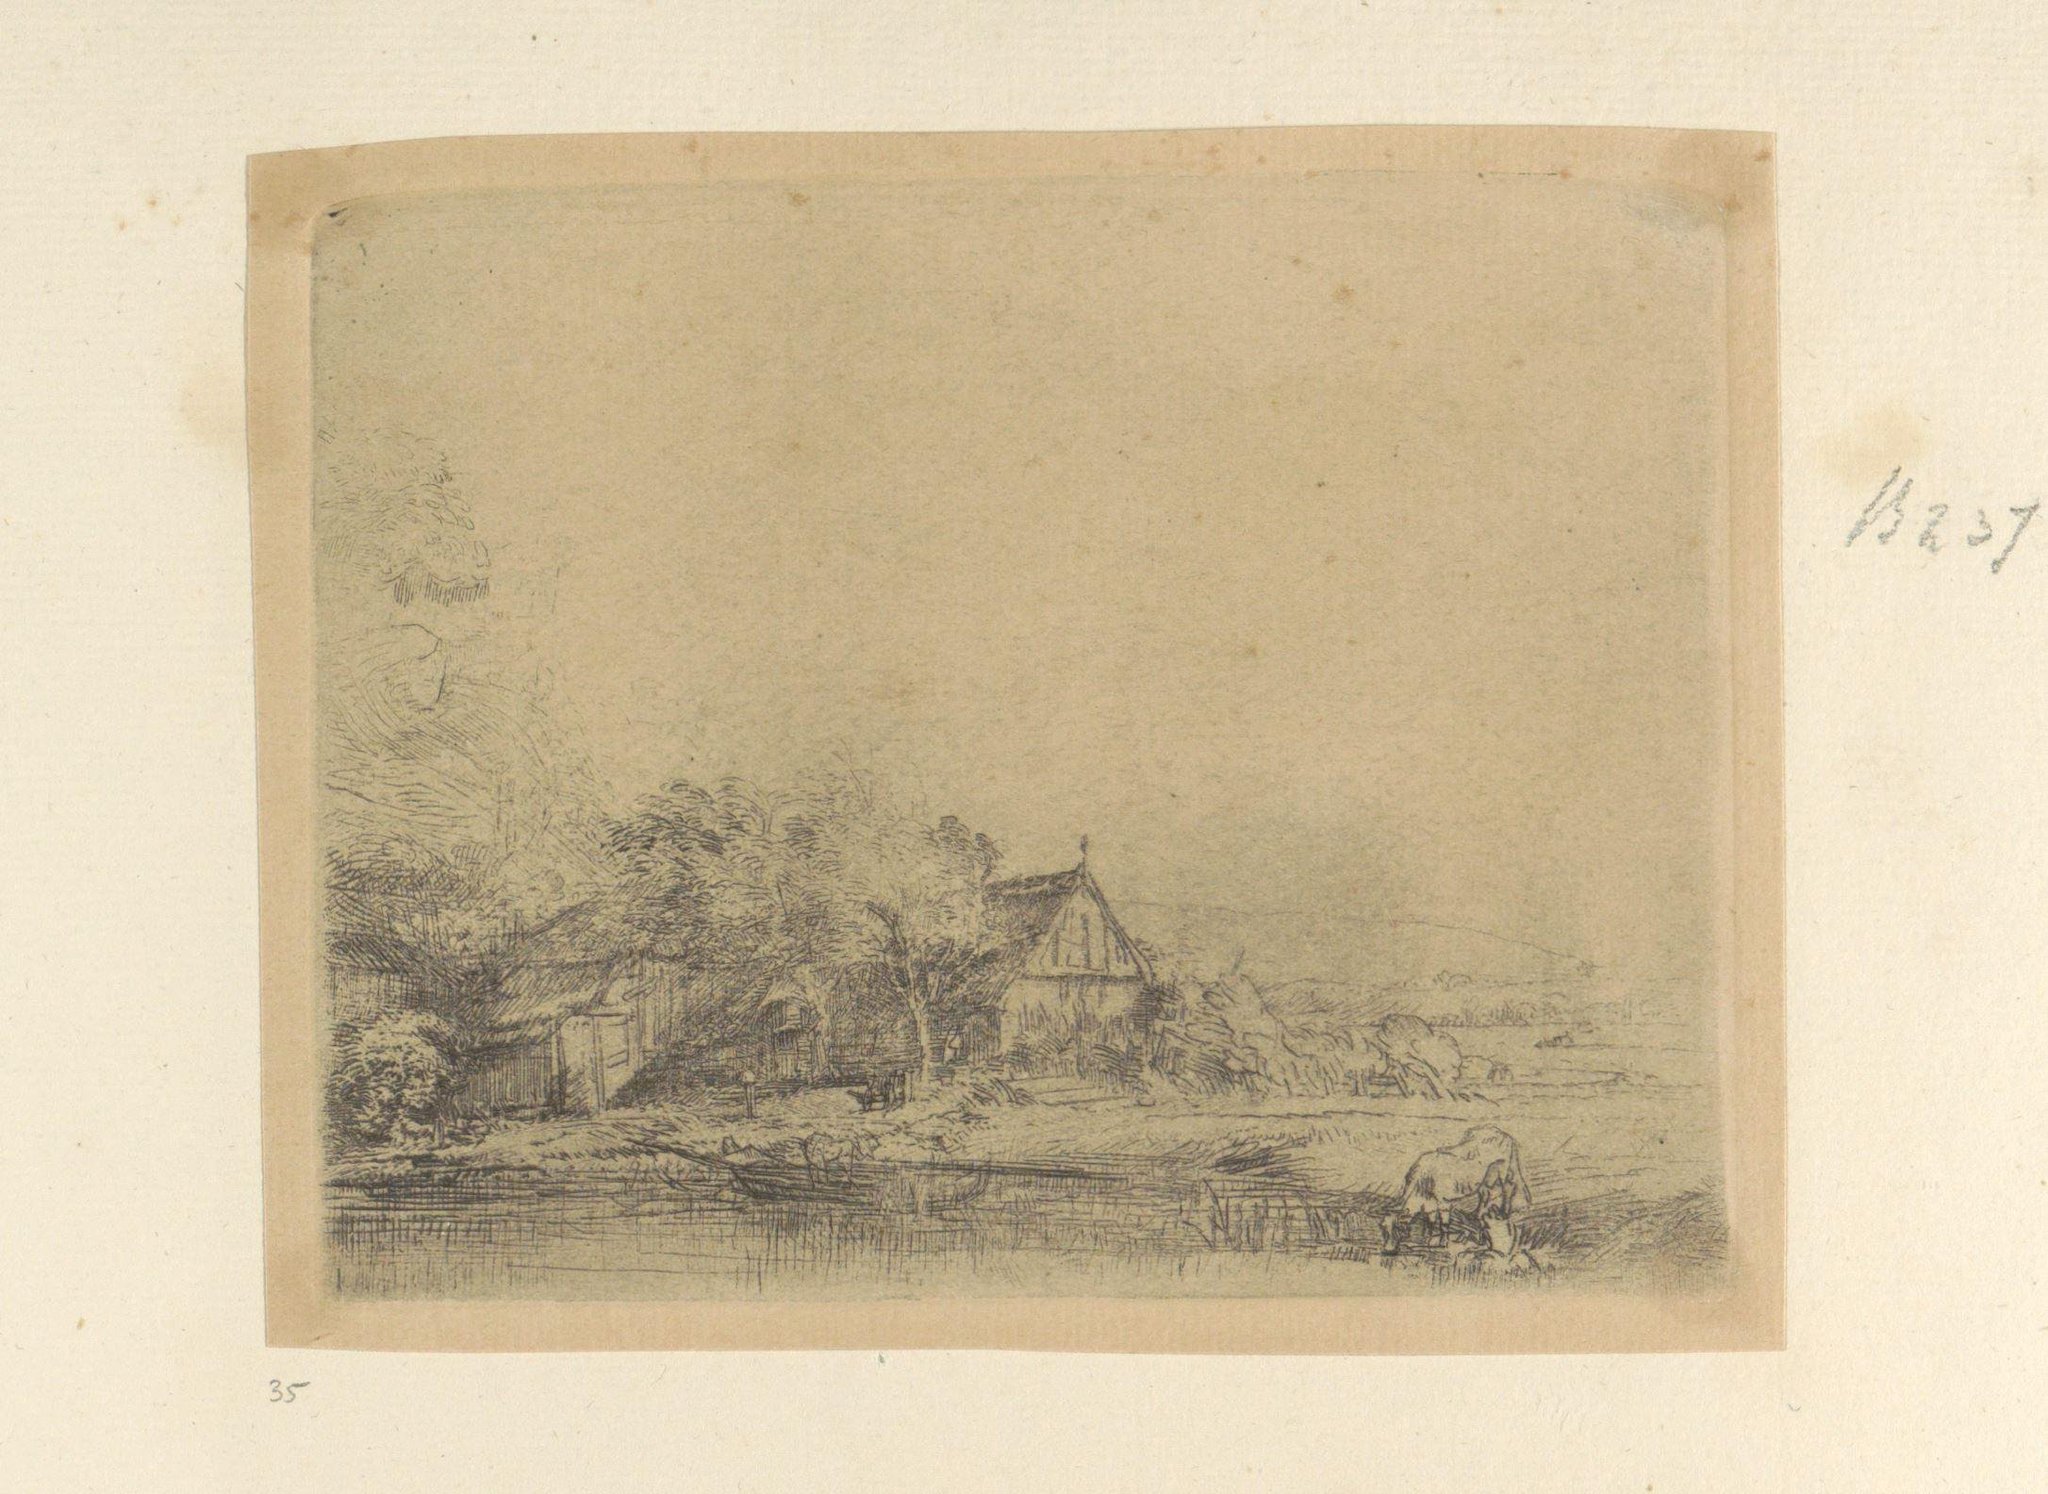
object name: print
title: Landschap met drinkende koe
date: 1648-1652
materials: paper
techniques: drypoint, etching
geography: paris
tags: cow